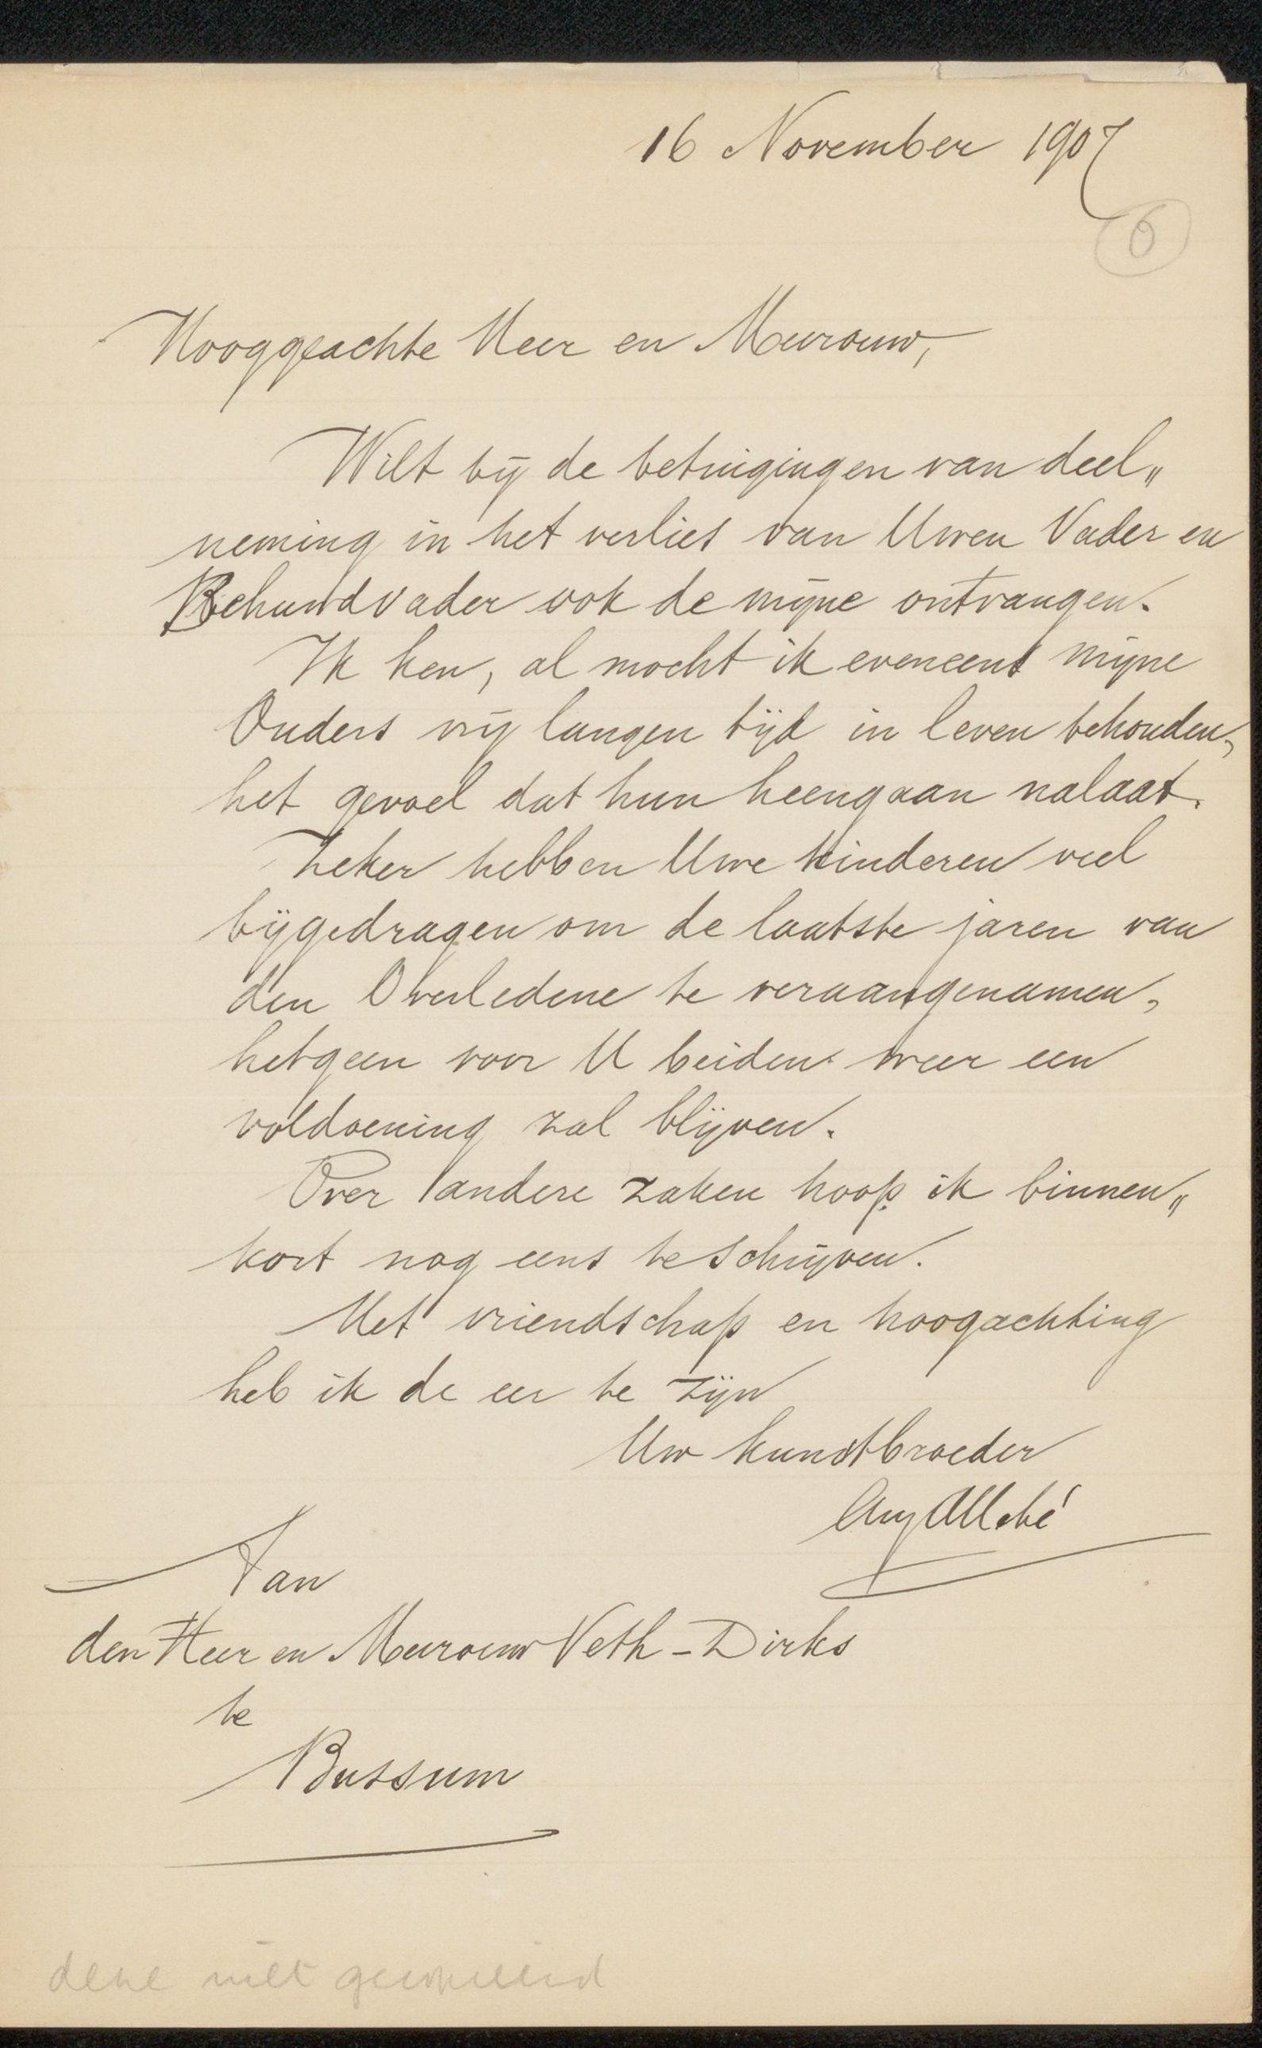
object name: letter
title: Brief aan Jan Veth en Anna Dorothea Dirks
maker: august allebé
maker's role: draughtsman, print maker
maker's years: 1838-1927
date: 1907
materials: ink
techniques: pen, writing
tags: dordrecht, painter, print maker, draughtsman, designer, jan veth, artist, anna dorothea dirks, family life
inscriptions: collector's mark: ‘RPK’